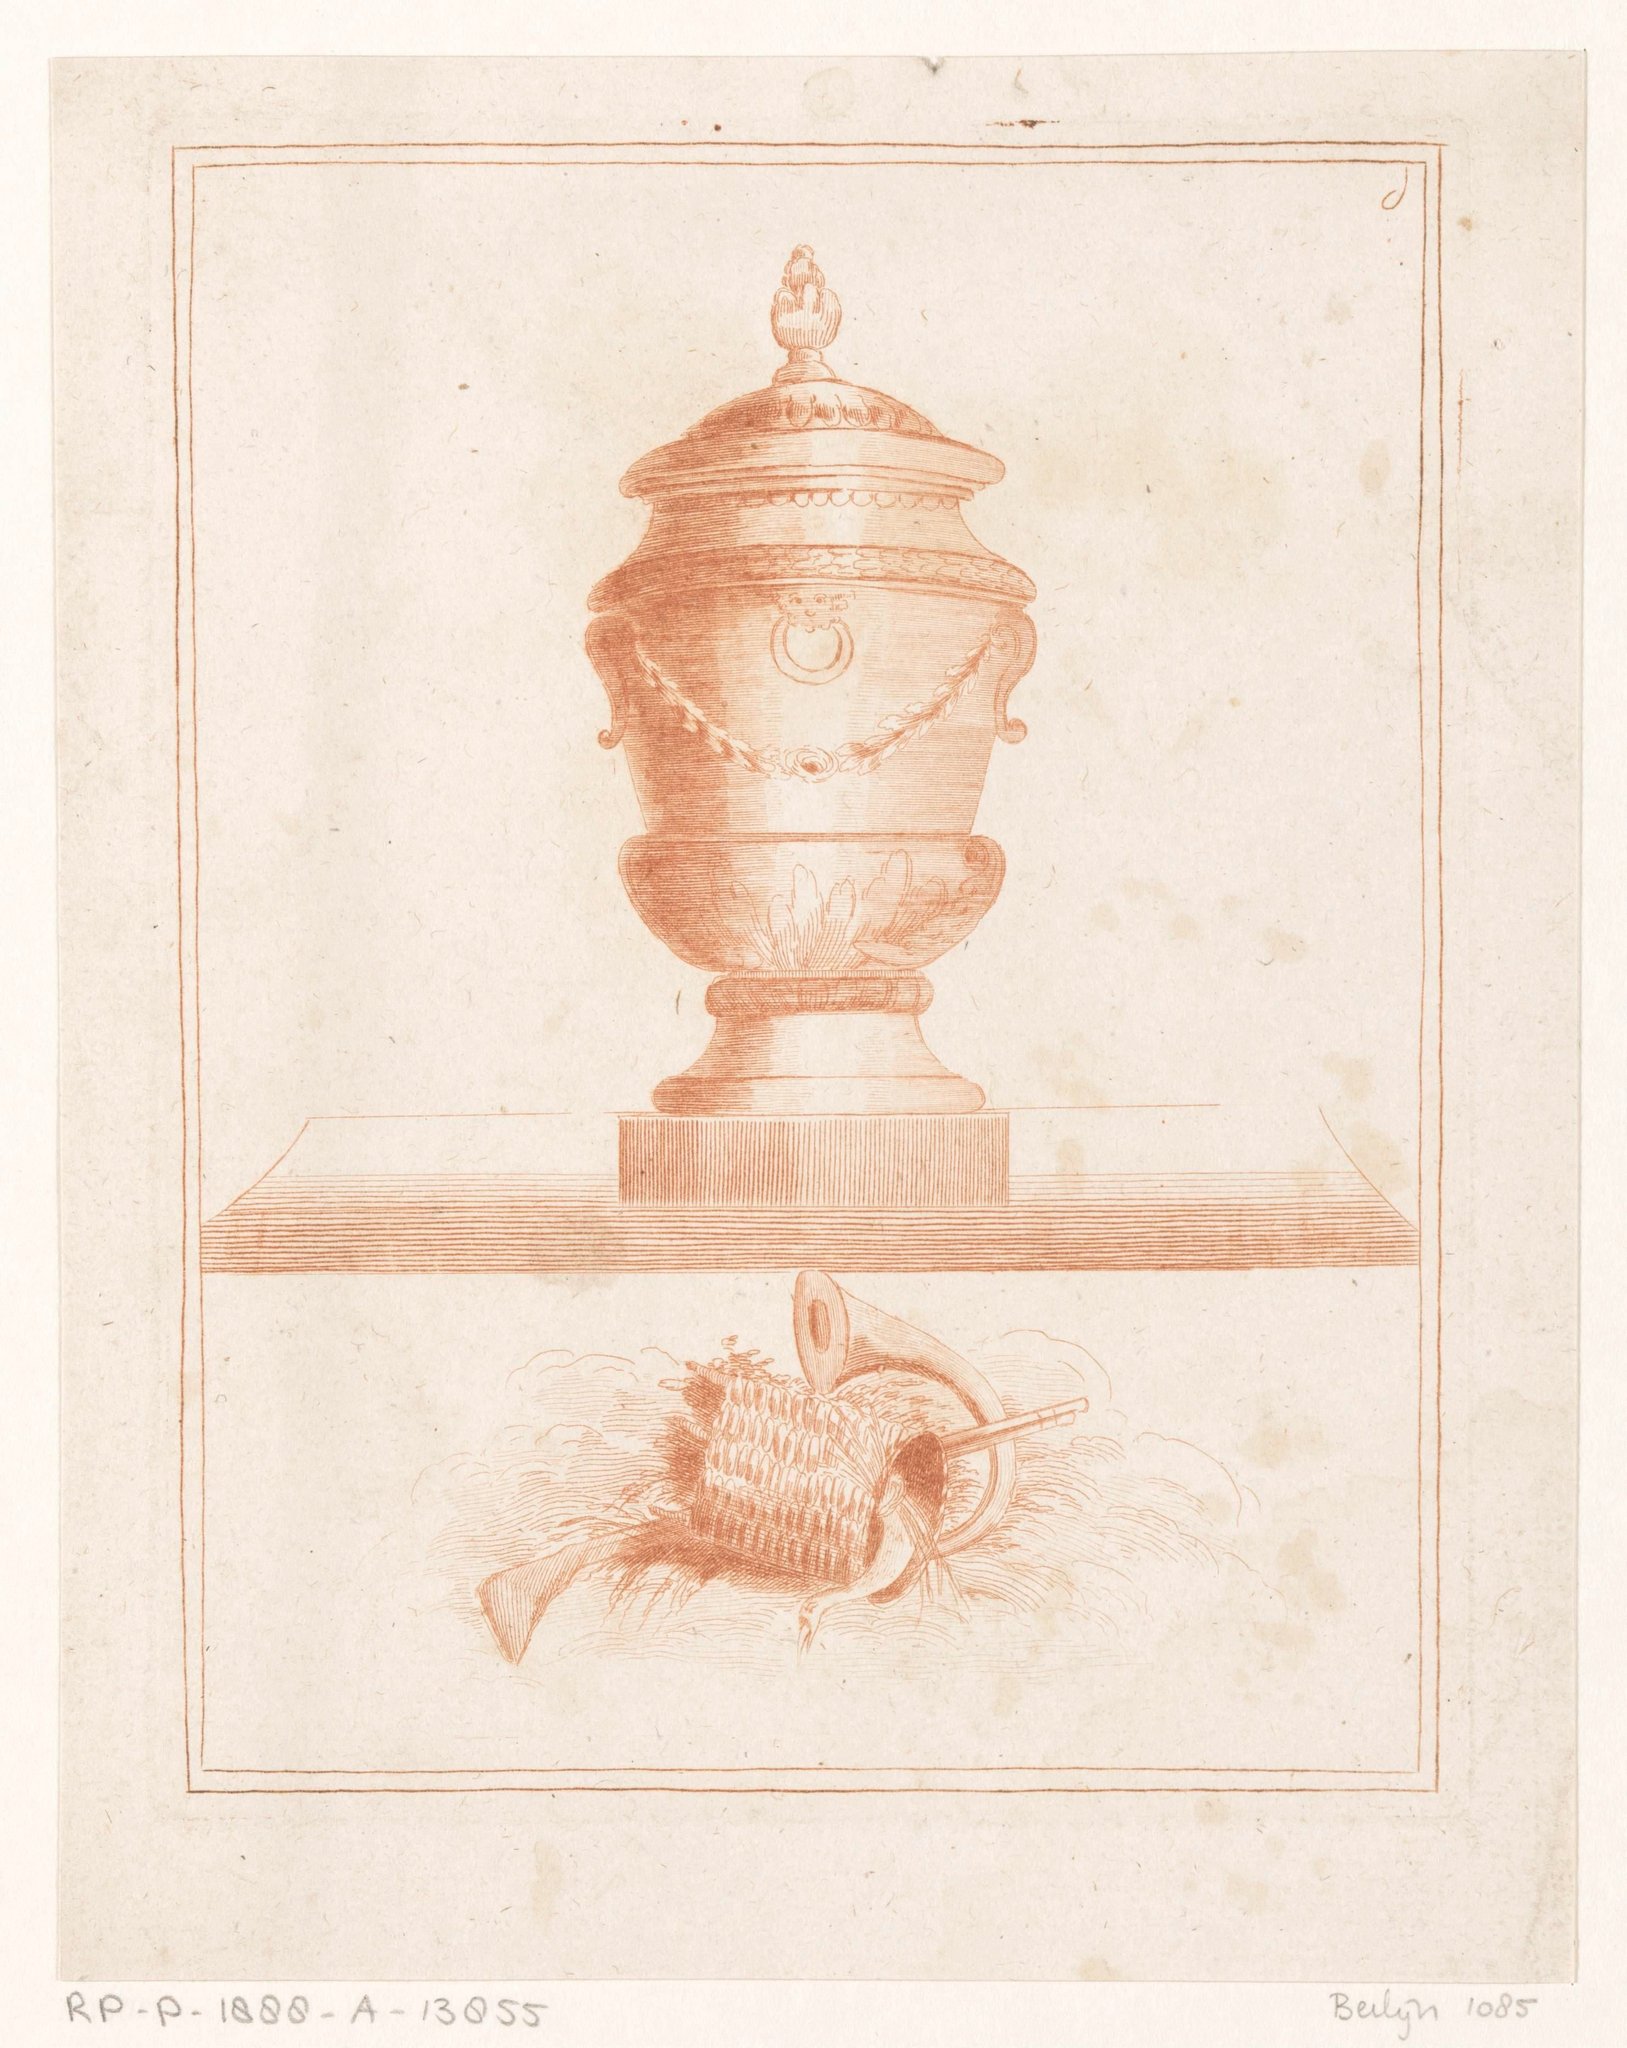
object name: print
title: Vaas met guirlande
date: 1768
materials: paper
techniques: etching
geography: paris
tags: vase ~ ornament, ornament ~ festoon, garland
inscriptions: collector's mark: Lugt 2228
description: Een geornamenteerde vaas met guirlande, daaronder een geweer, een jachthoorn en een mand met een vogel.